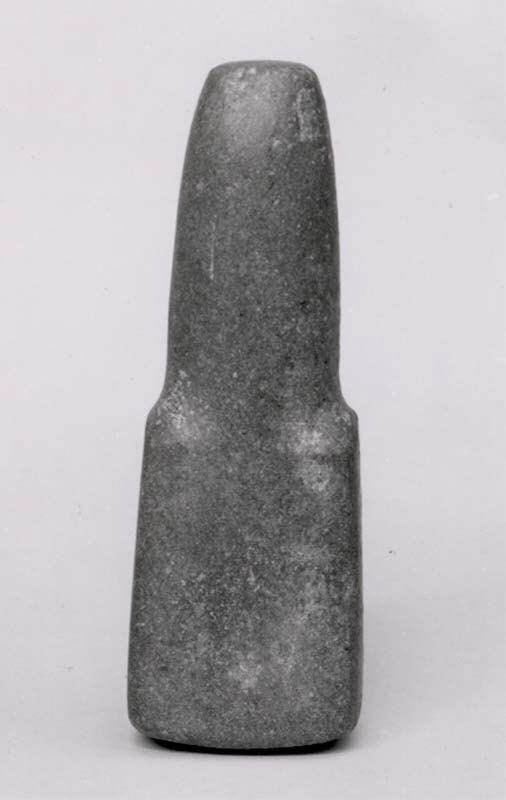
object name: pestle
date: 1000-1 BCE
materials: stone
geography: iran